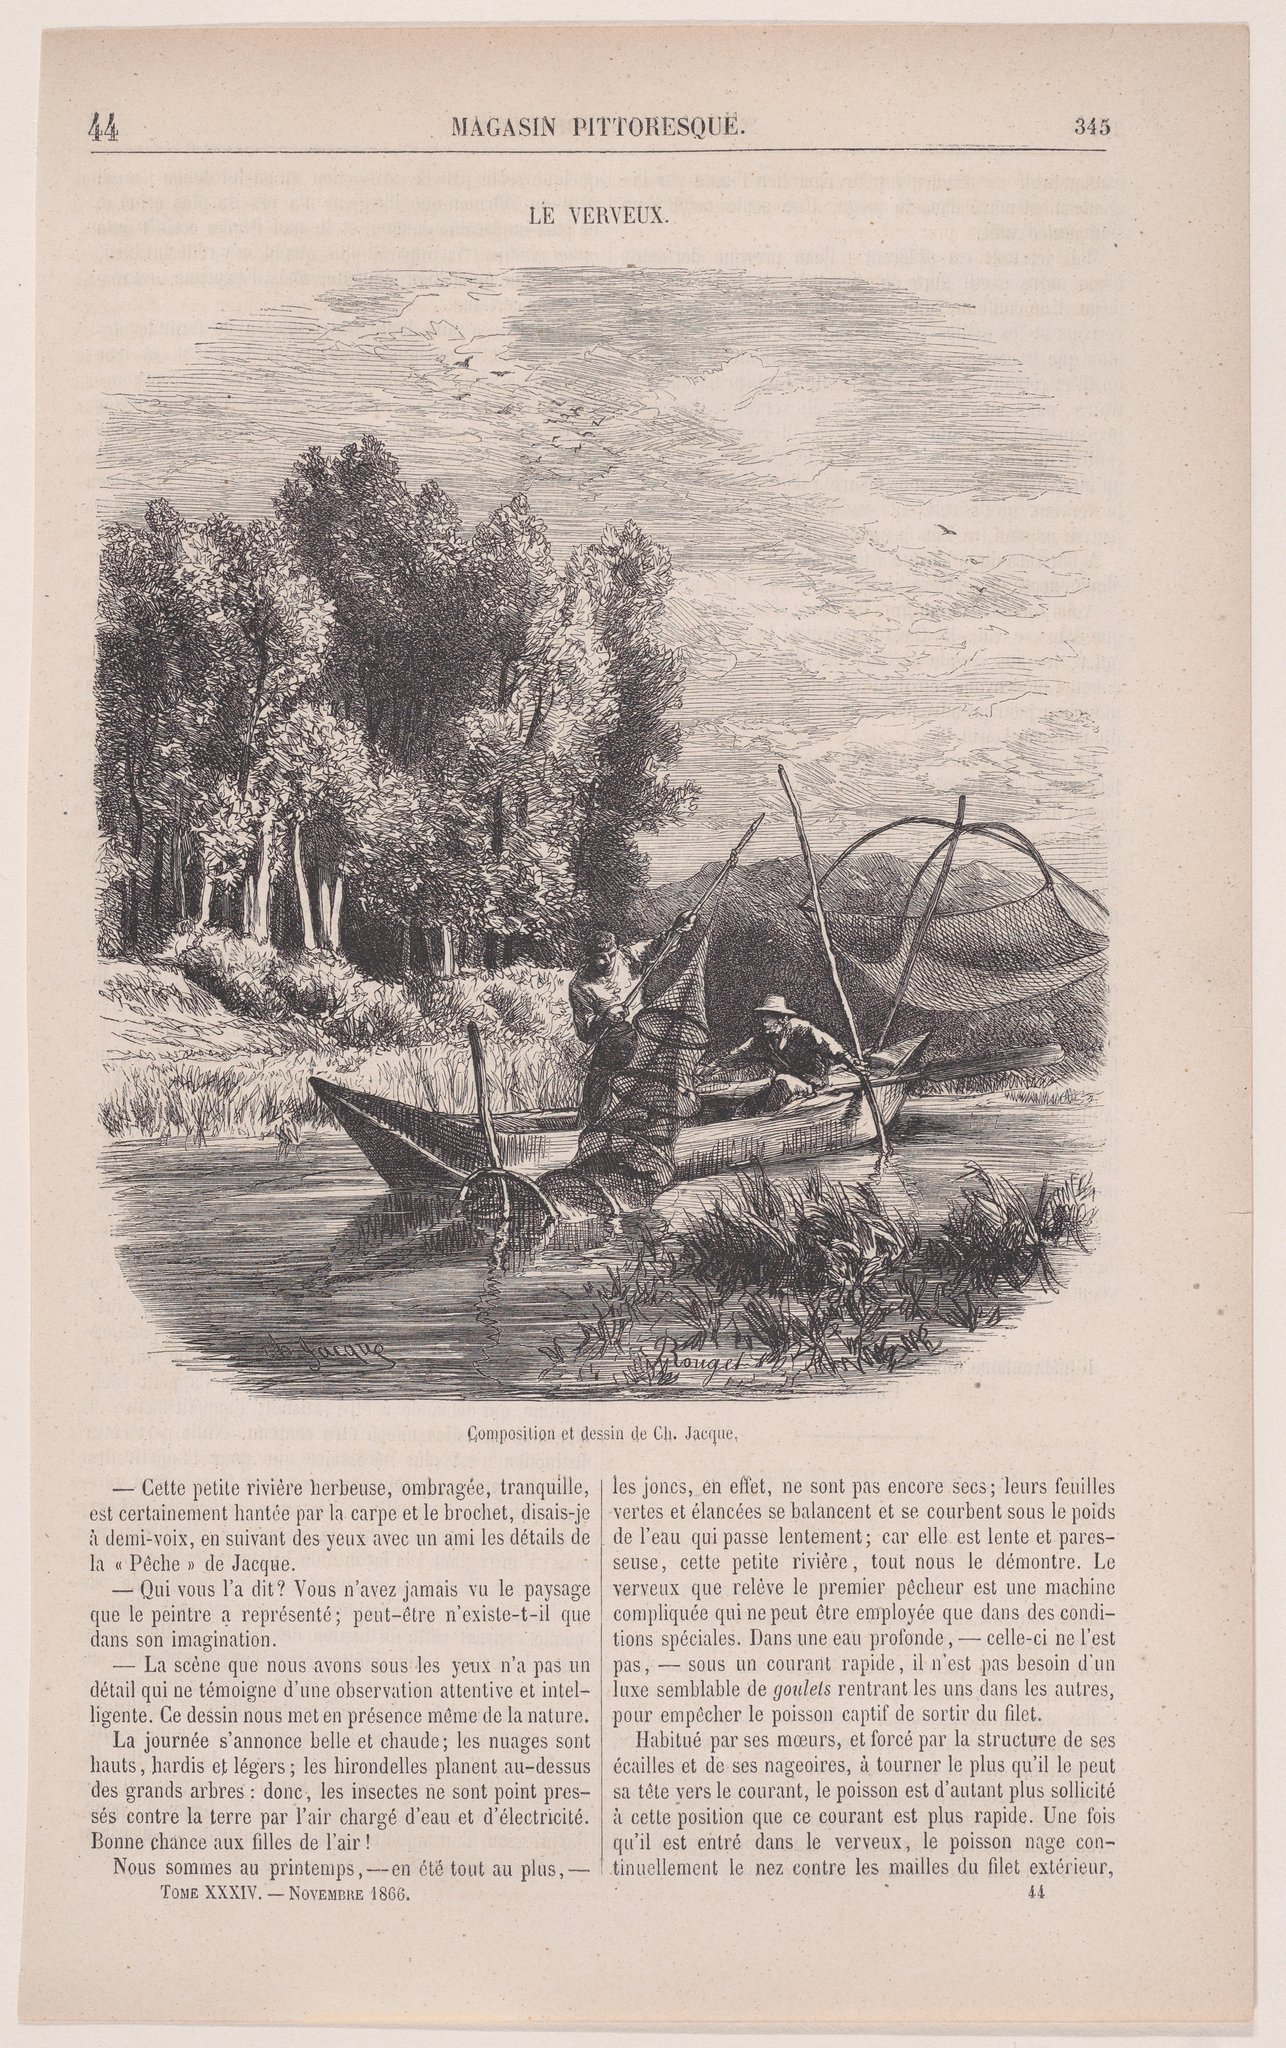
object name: print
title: Le Verveux, from "Le Magasin Pittoresque"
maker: charles émile jacque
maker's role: artist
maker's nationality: french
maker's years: 1813-1894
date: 1852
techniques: engraving